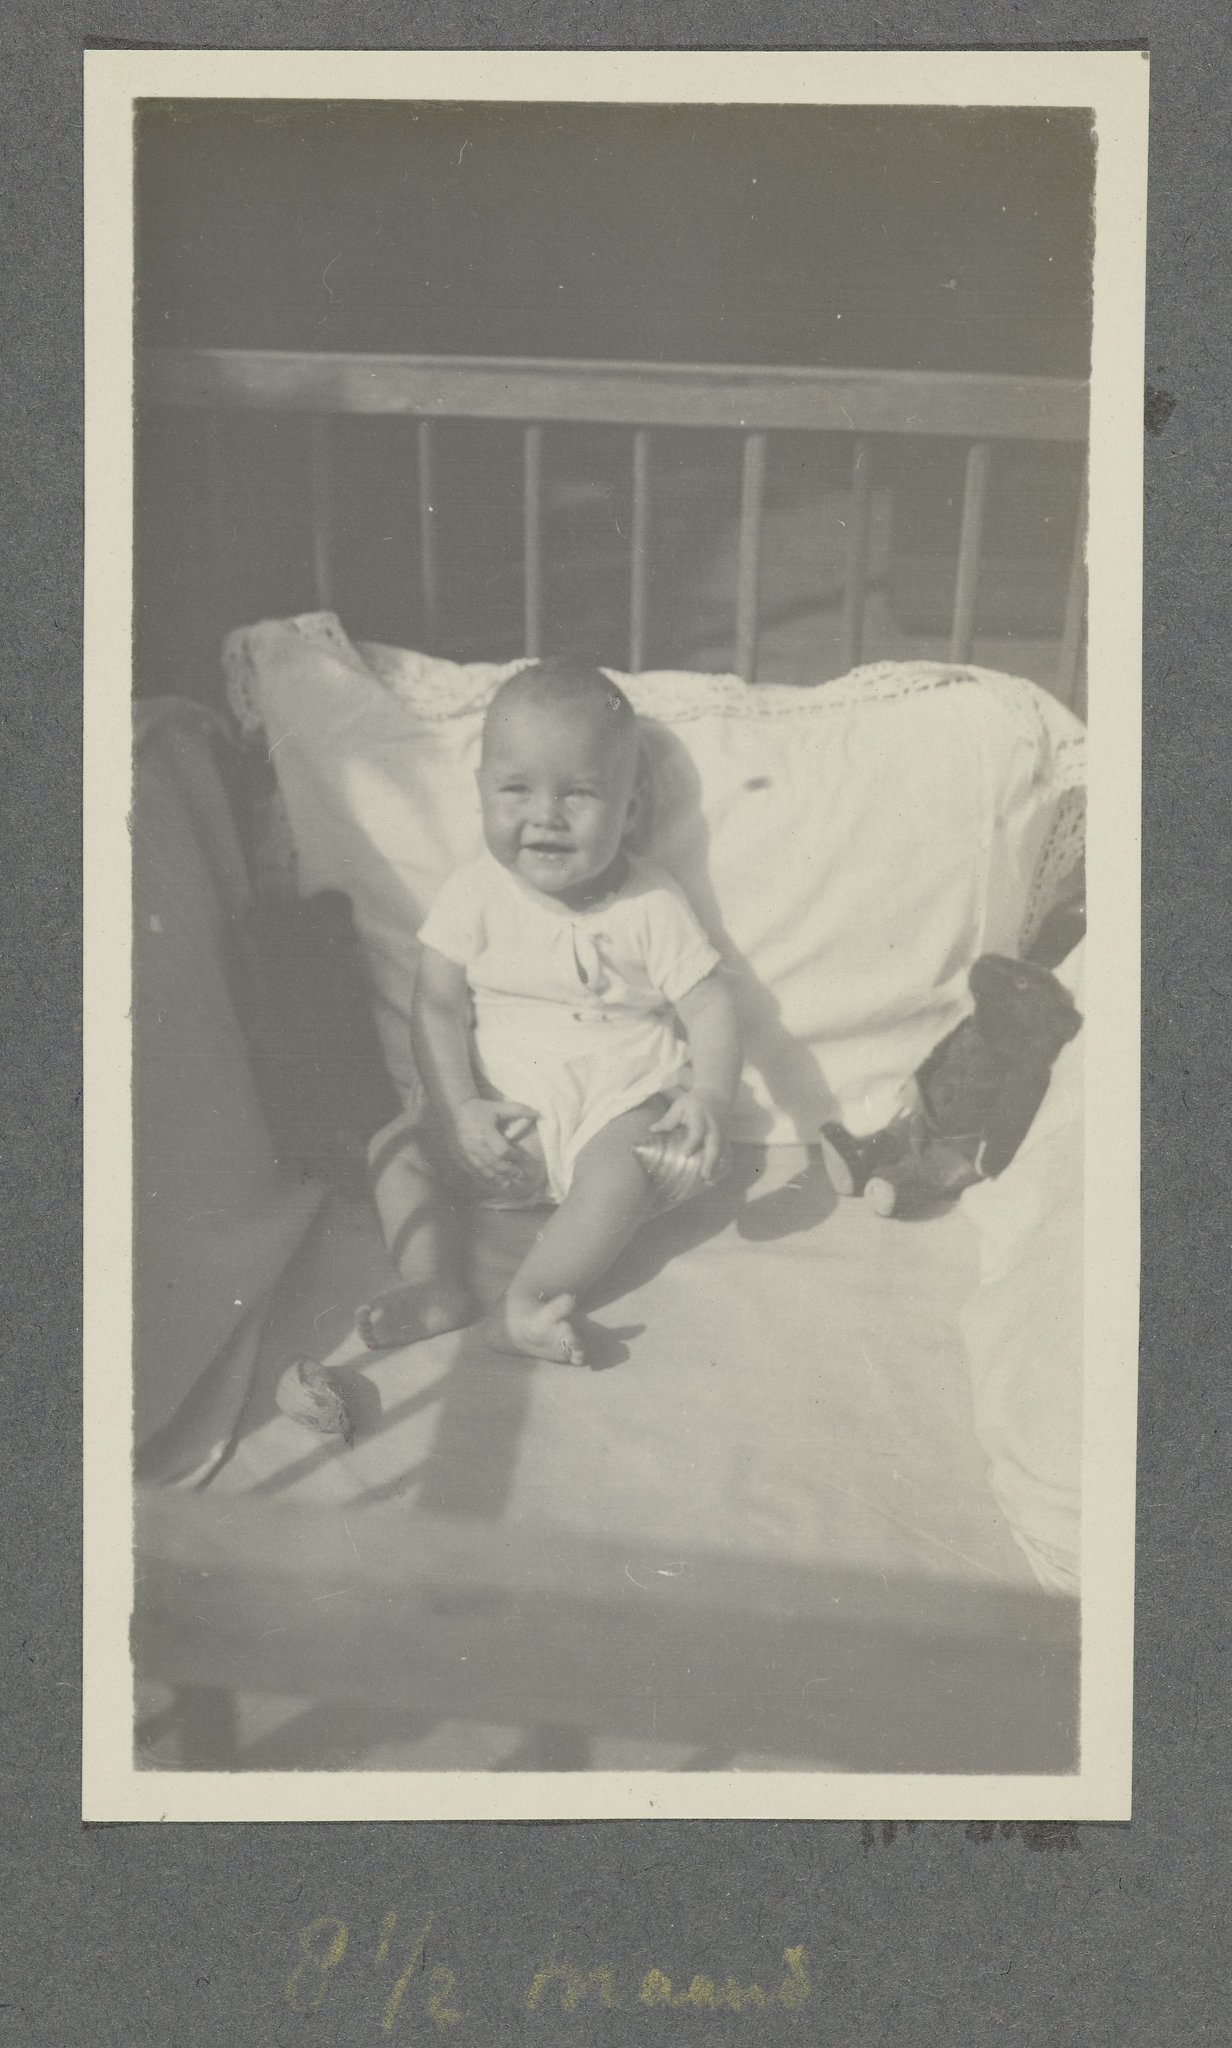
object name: photograph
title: Acht en een halve maand oude baby Klaas Kleiterp in een box, vermoedelijk in Malang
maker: klaas kleiterp (i)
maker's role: arts, officier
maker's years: 1892-1943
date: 1920-1921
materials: paper, photographic support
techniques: gelatin silver print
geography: malang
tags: infant, baby ~ the ages of man, dutch east indies, the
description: Onderdeel van Fotoalbum van de familie Kleiterp-Vermeulen met opnames van de kinderen Klaas en Tiny in Nederlands-Indië.